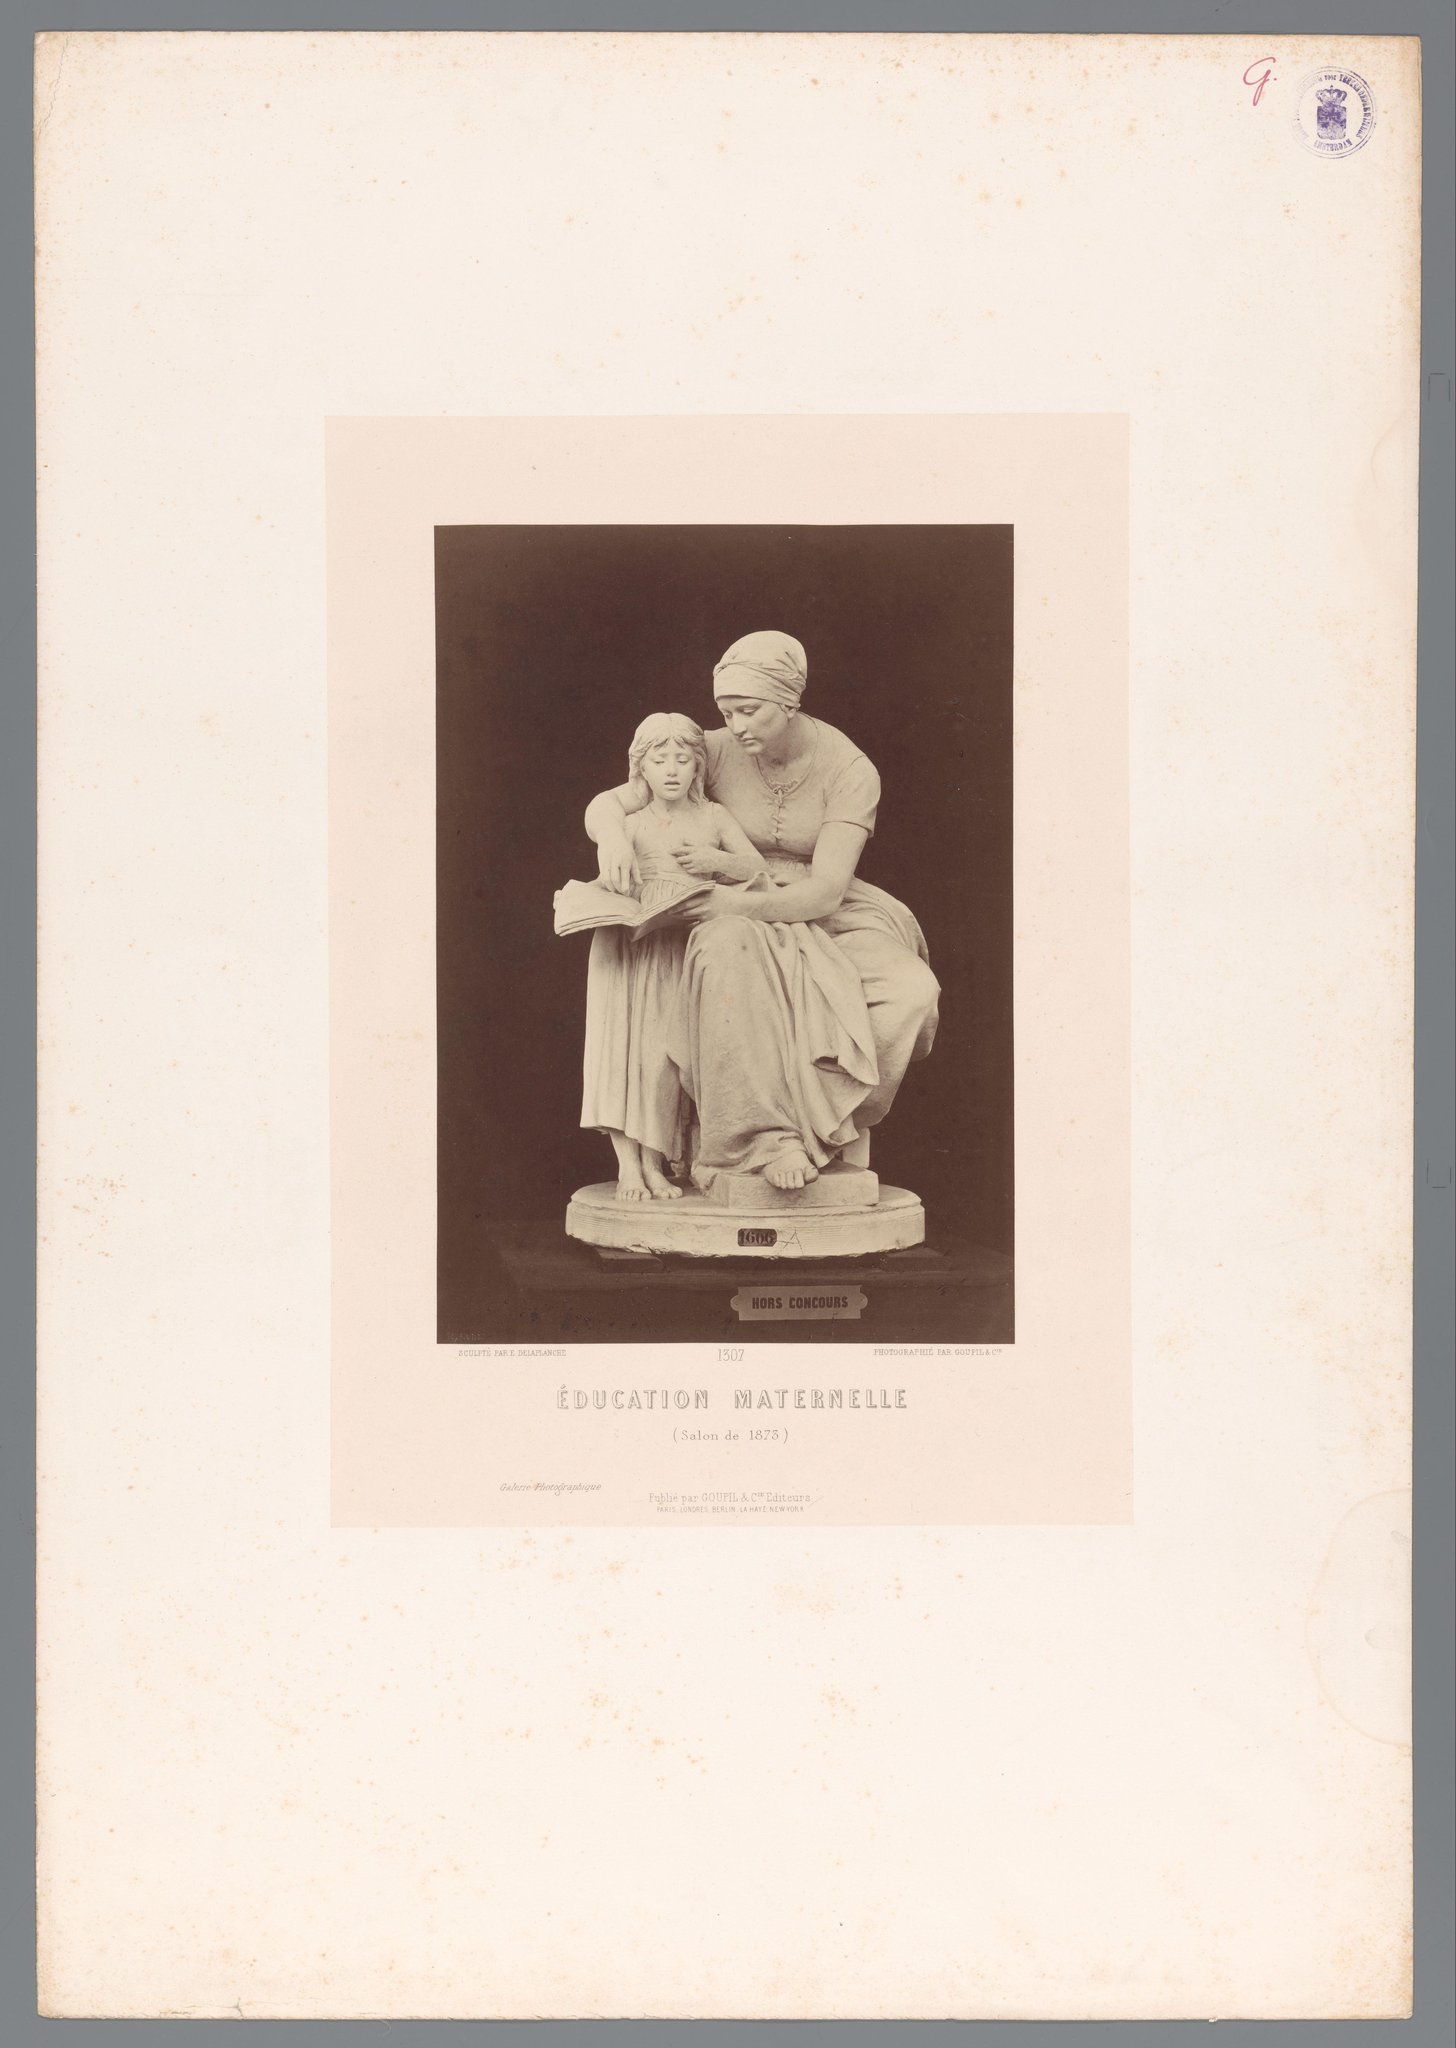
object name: photograph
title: Éducation maternelle (Salon de 1873)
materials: cardboard, paper, photographic support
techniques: albumen print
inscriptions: stamp, : ‘G’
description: Sculptuur door Delaplanche van een zittende moeder die samen met haar staande dochter leest.